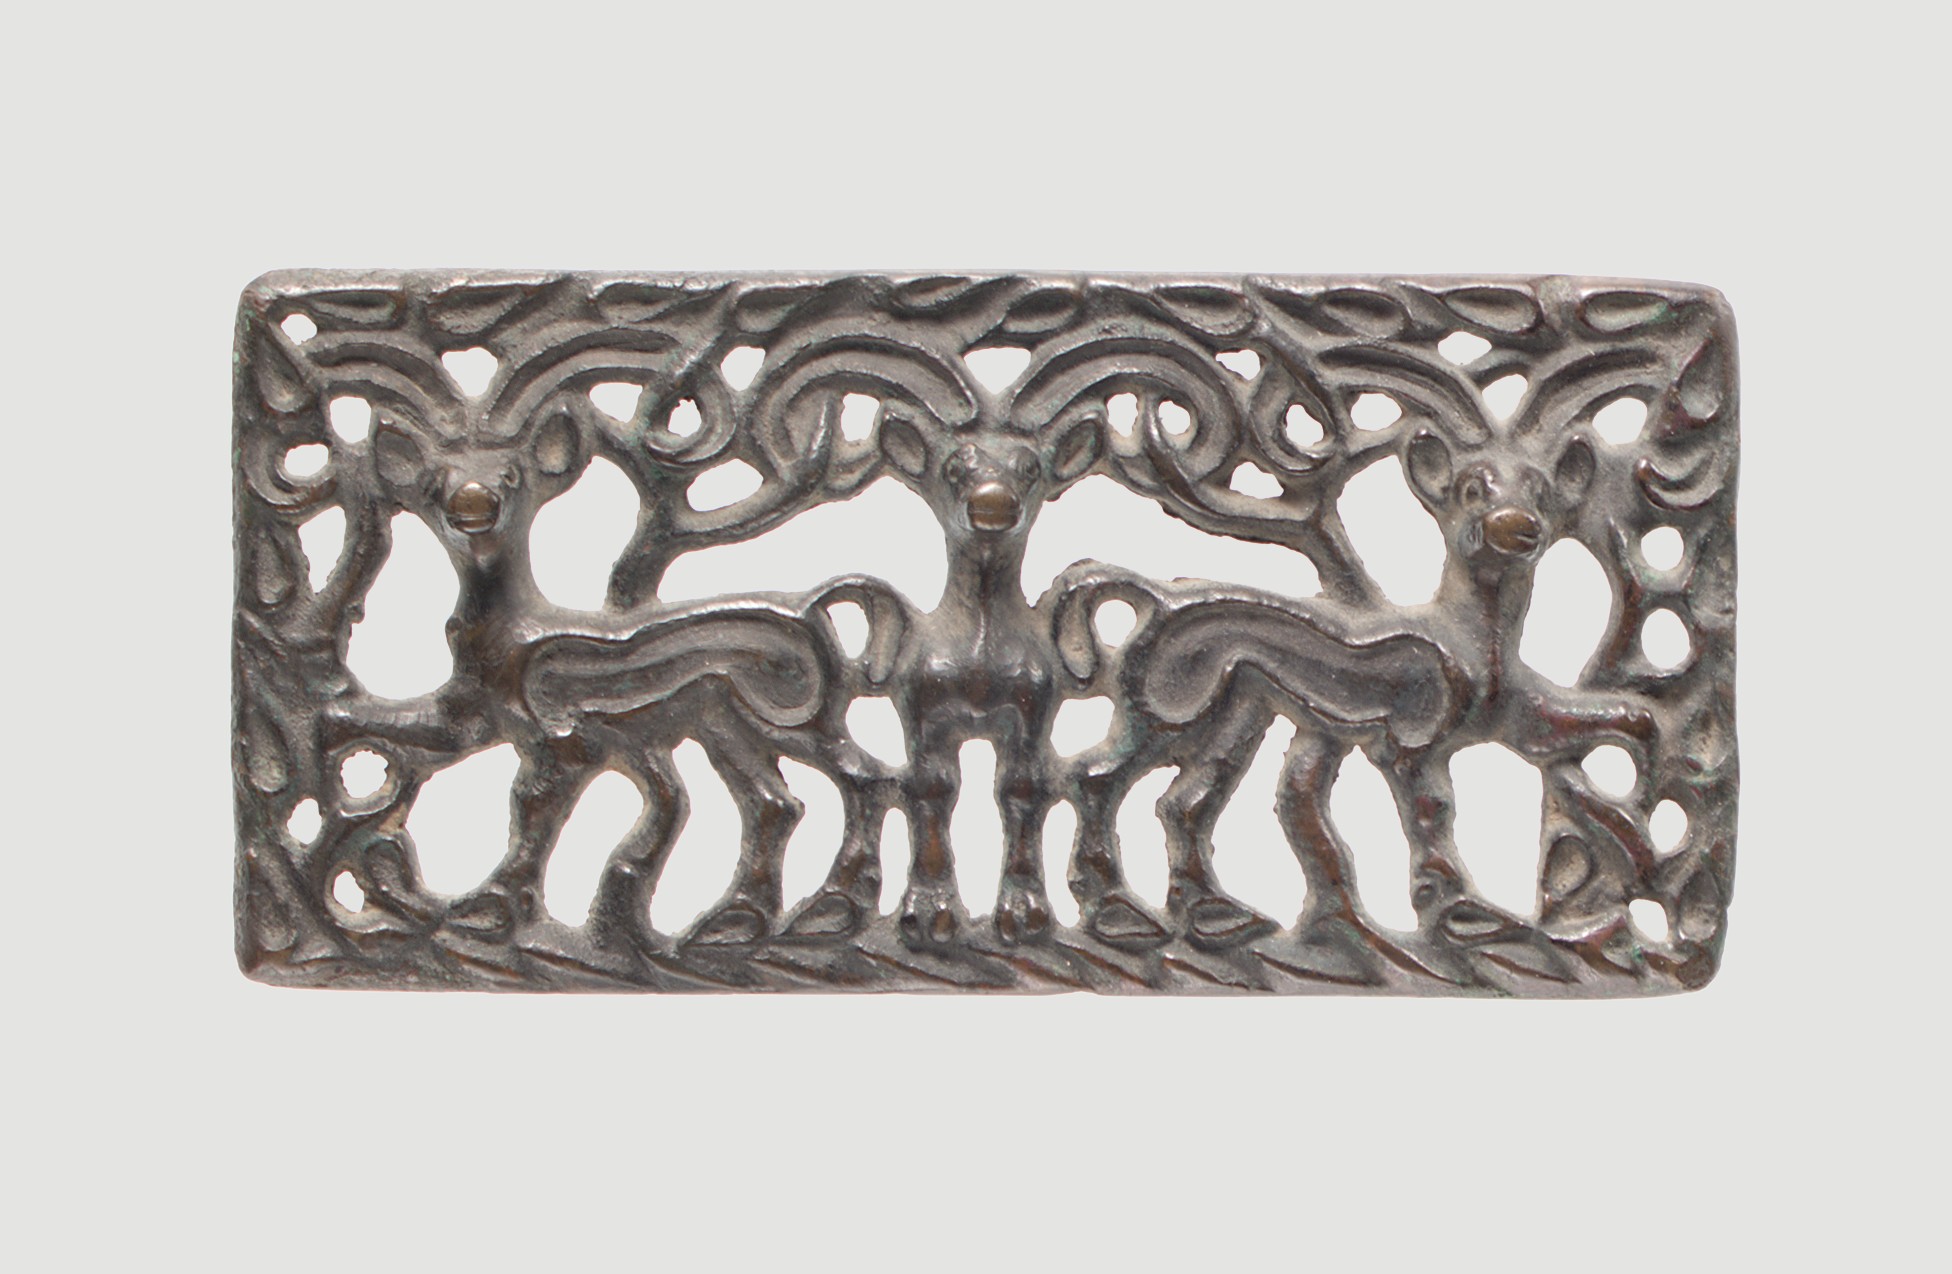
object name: belt plaque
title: Belt Plaque with Three Ibexes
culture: northwest chinese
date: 200-1 BCE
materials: bronze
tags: ibex